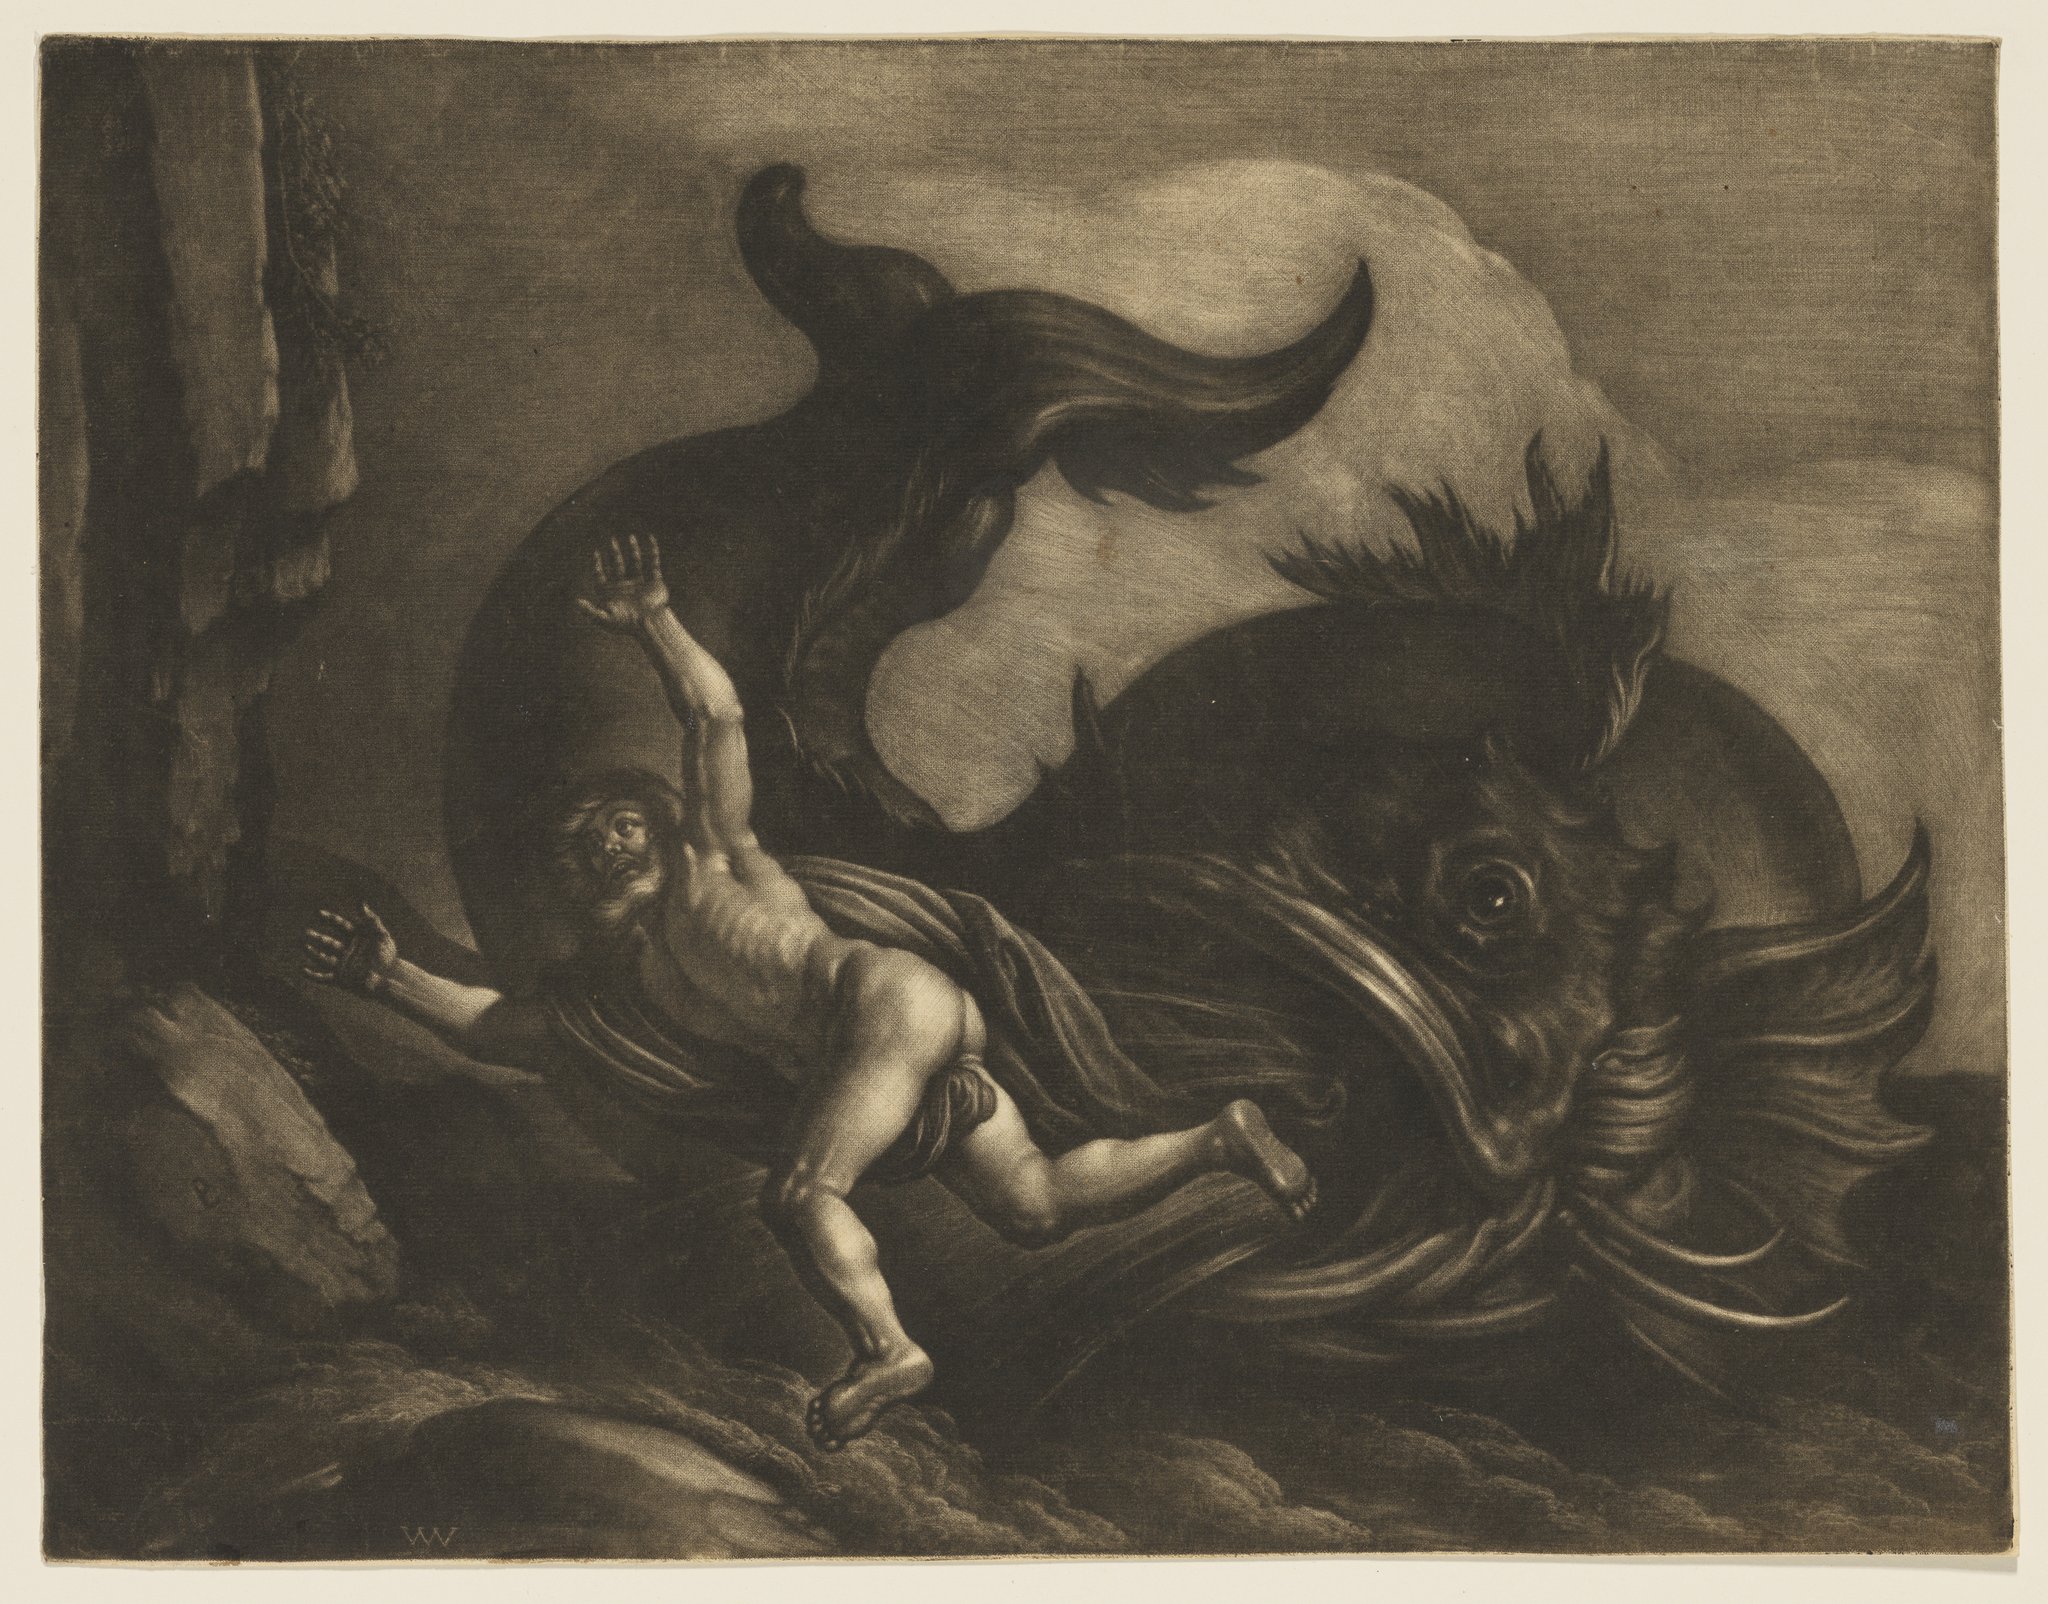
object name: print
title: The Prophet Jonas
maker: wallerant vaillant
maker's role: artist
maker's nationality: dutch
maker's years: 1623-1677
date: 1634-1666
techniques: mezzotint